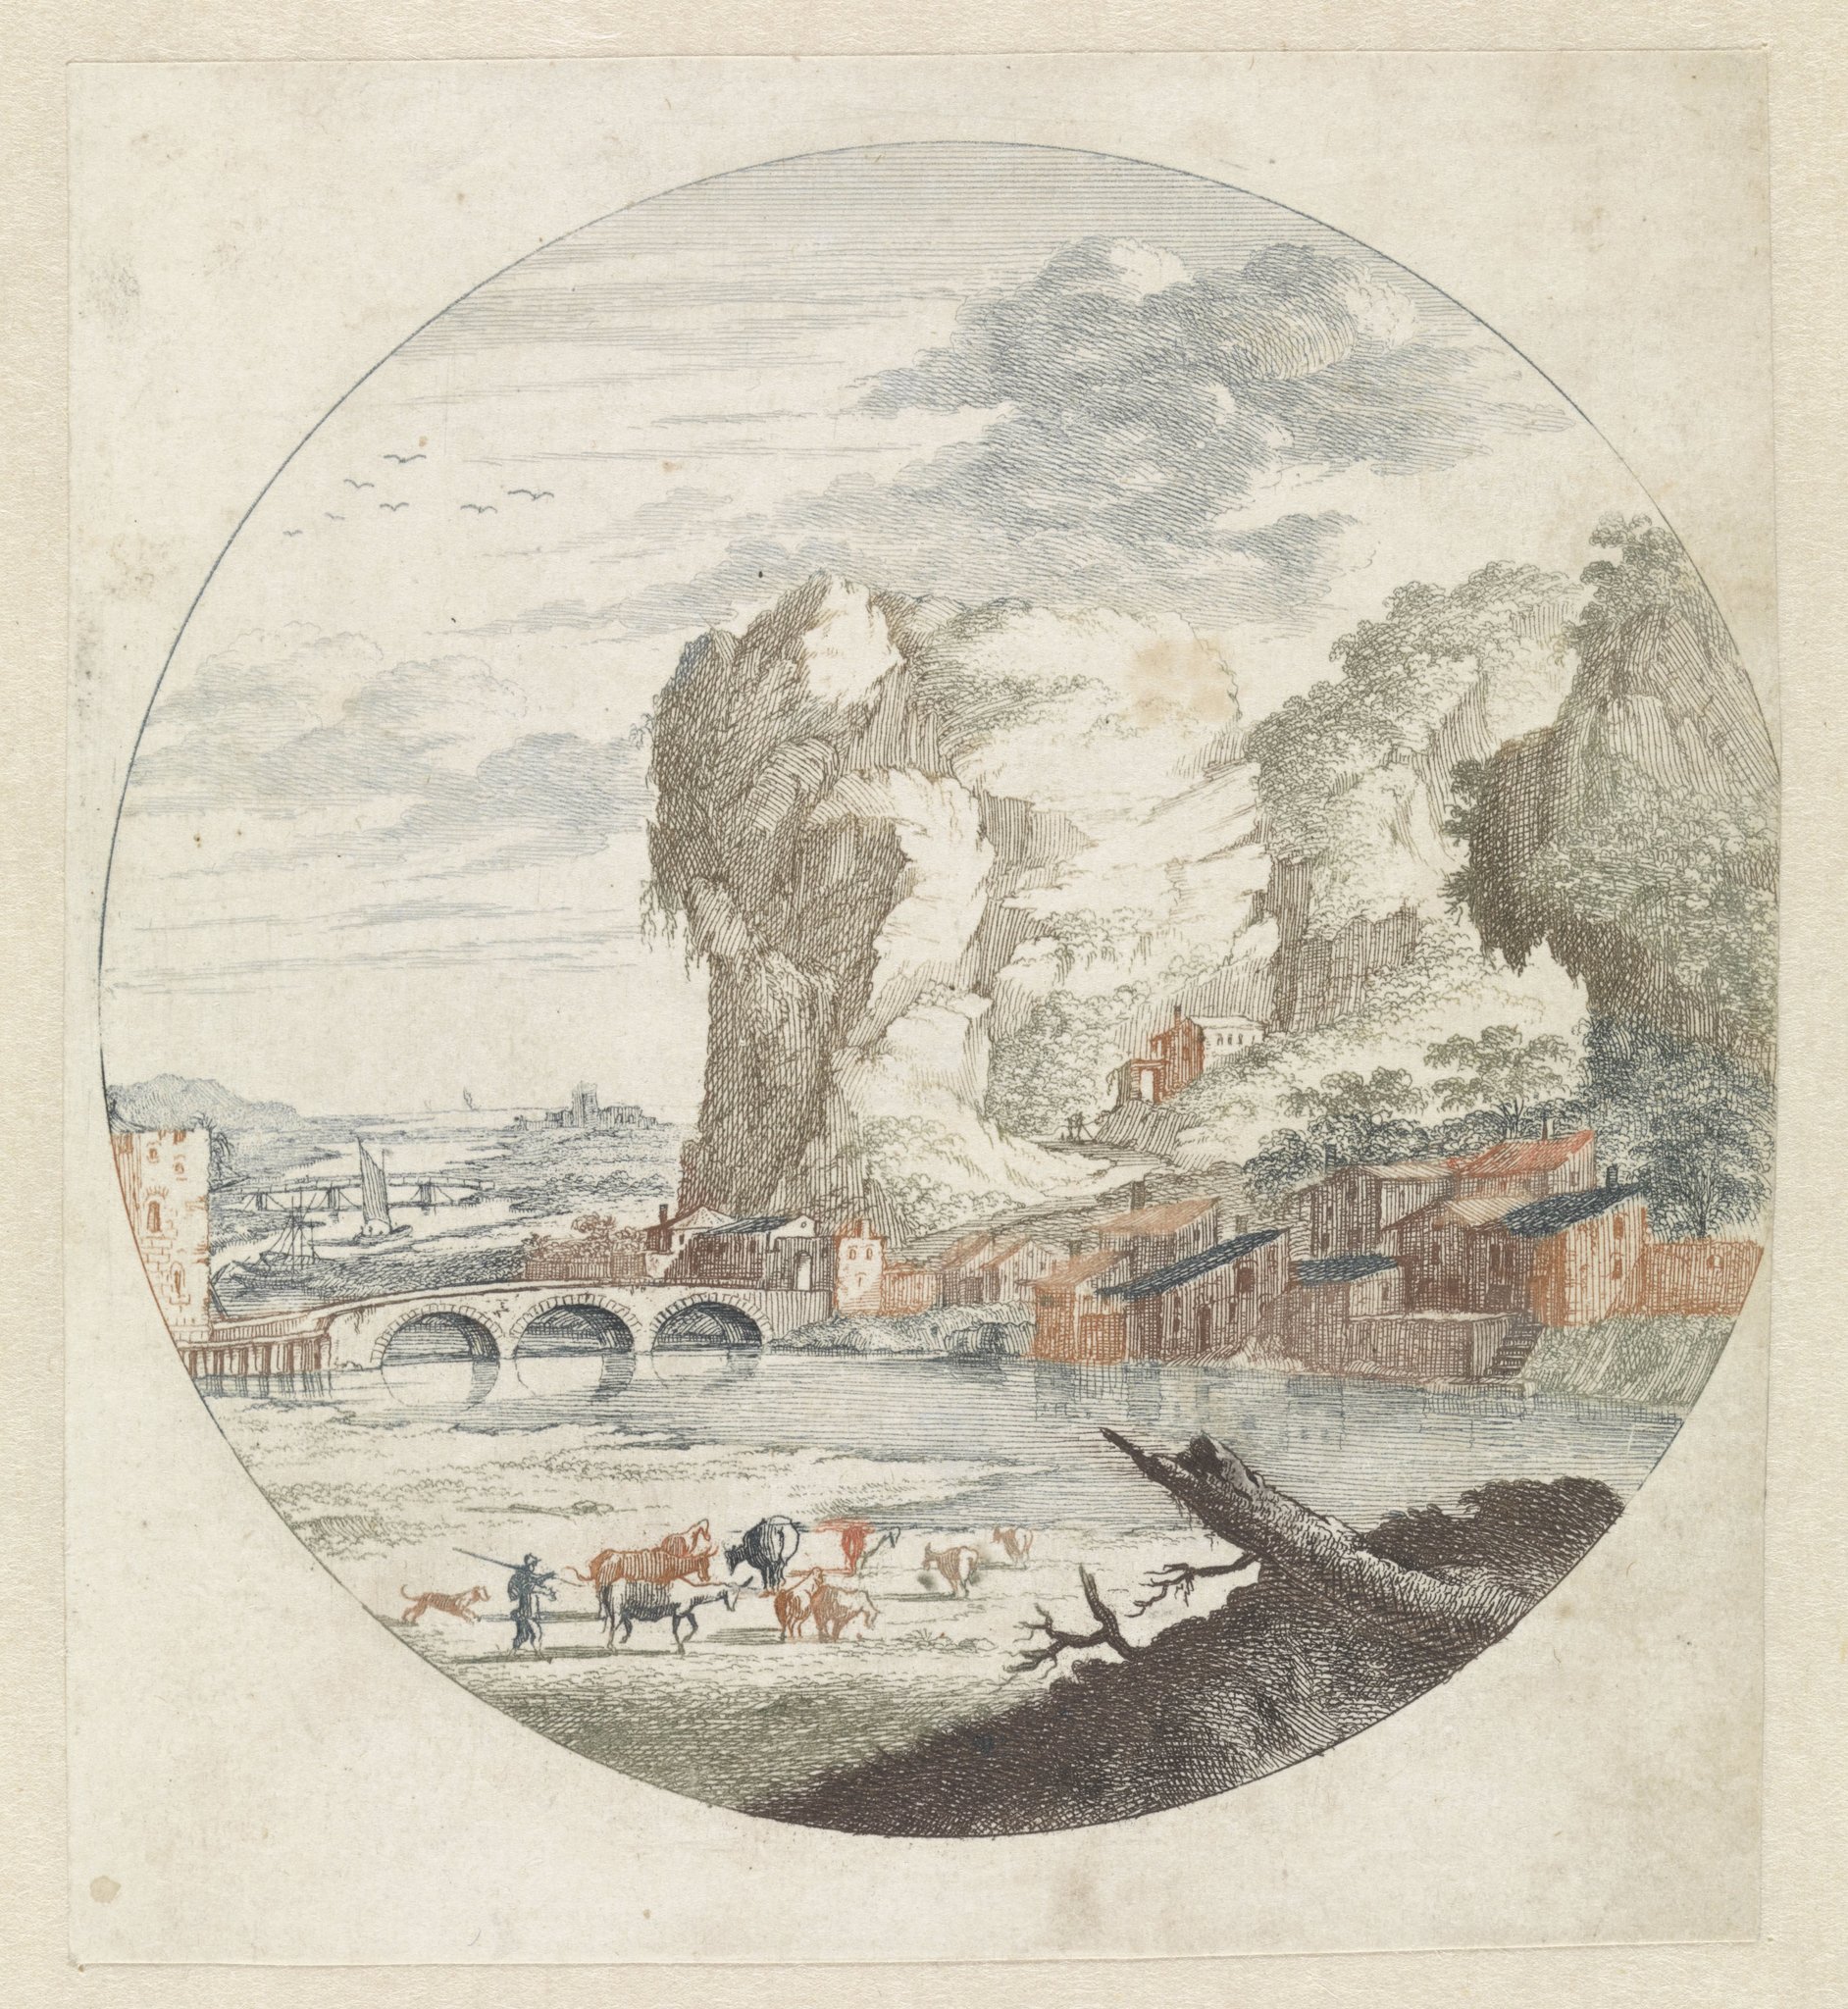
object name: print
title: Landschap met rivier en rotsen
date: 1688-1698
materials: paper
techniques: etching, lithography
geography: netherlands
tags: river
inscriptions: collector's mark: Lugt 2760, collector's mark: Lugt 2228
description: Landschap met een rivier en rotsen rechts. Op de voorgrond een herder met zijn vee.